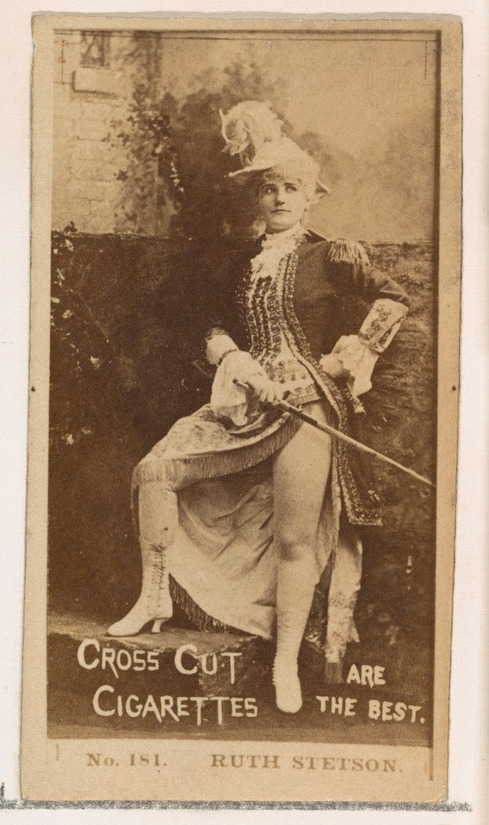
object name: print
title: Card Number 181, Ruth Stetson, from the Actors and Actresses series (N145-2) issued by Duke Sons & Co. to promote Cross Cut Cigarettes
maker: w. duke, sons & co.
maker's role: publisher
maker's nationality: american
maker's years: 1870-1920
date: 1880-1889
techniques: albumen silver print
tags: portraits,women,actresses